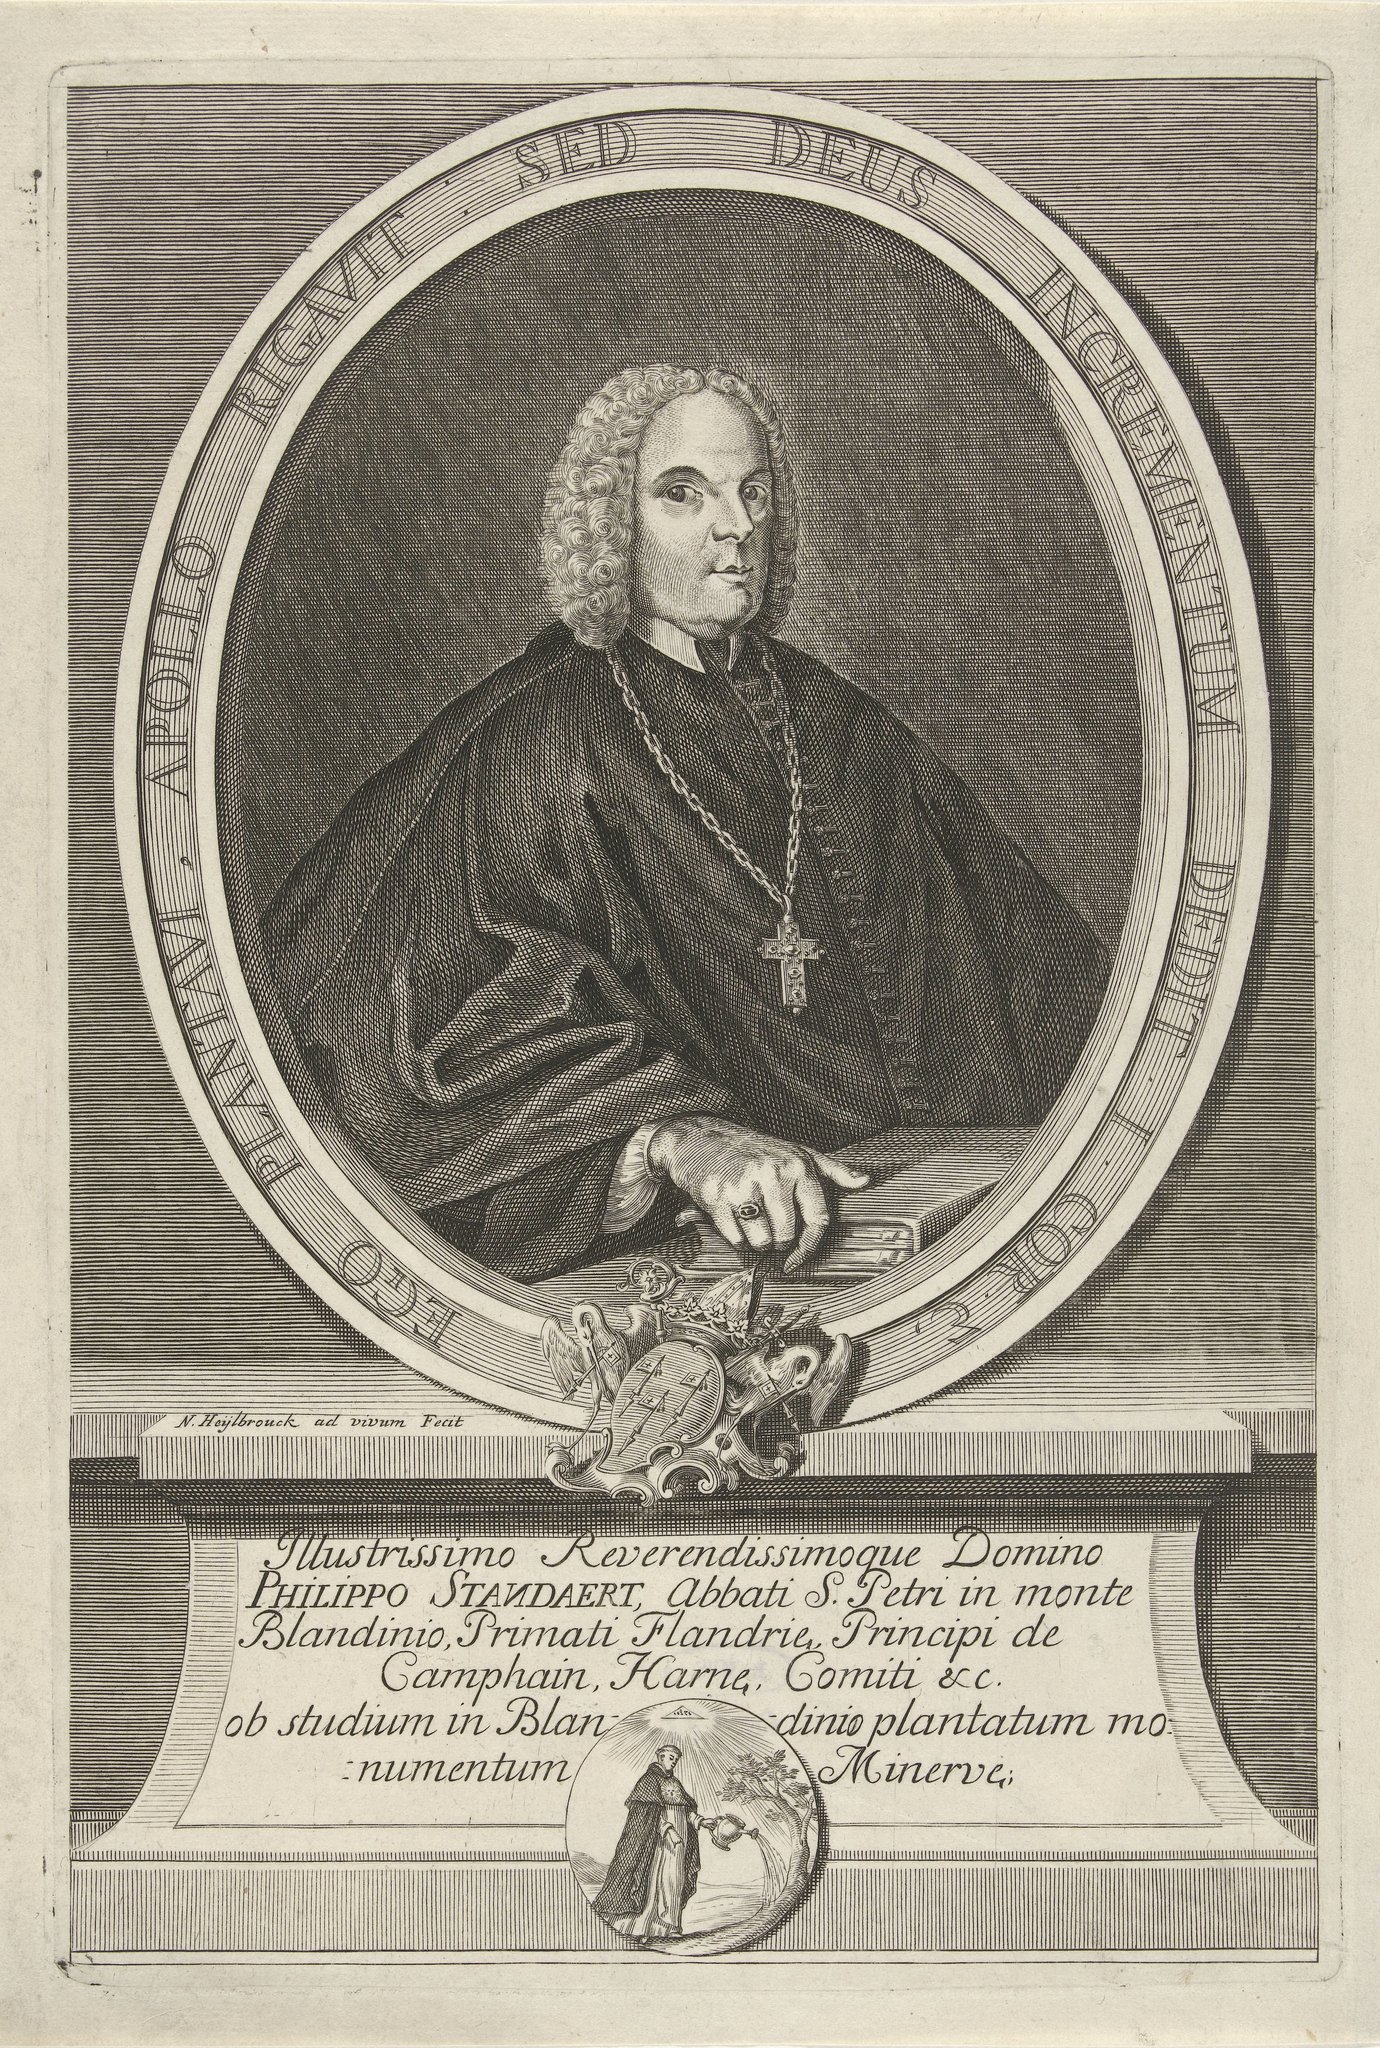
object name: print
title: Portret van Philippo Standaert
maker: norbert heylbrouck (i)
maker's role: print maker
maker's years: 1675-1762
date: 1685-1762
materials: paper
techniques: engraving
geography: southern netherlands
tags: philippo standaert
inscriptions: collector's mark: Lugt 2228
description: Portret ten halven lijve van Philippo Standaert in een ovaal. Onder het portret een zesregelige tekst in het Latijn en een afbeelding van een geestelijke die een boom water geeft.